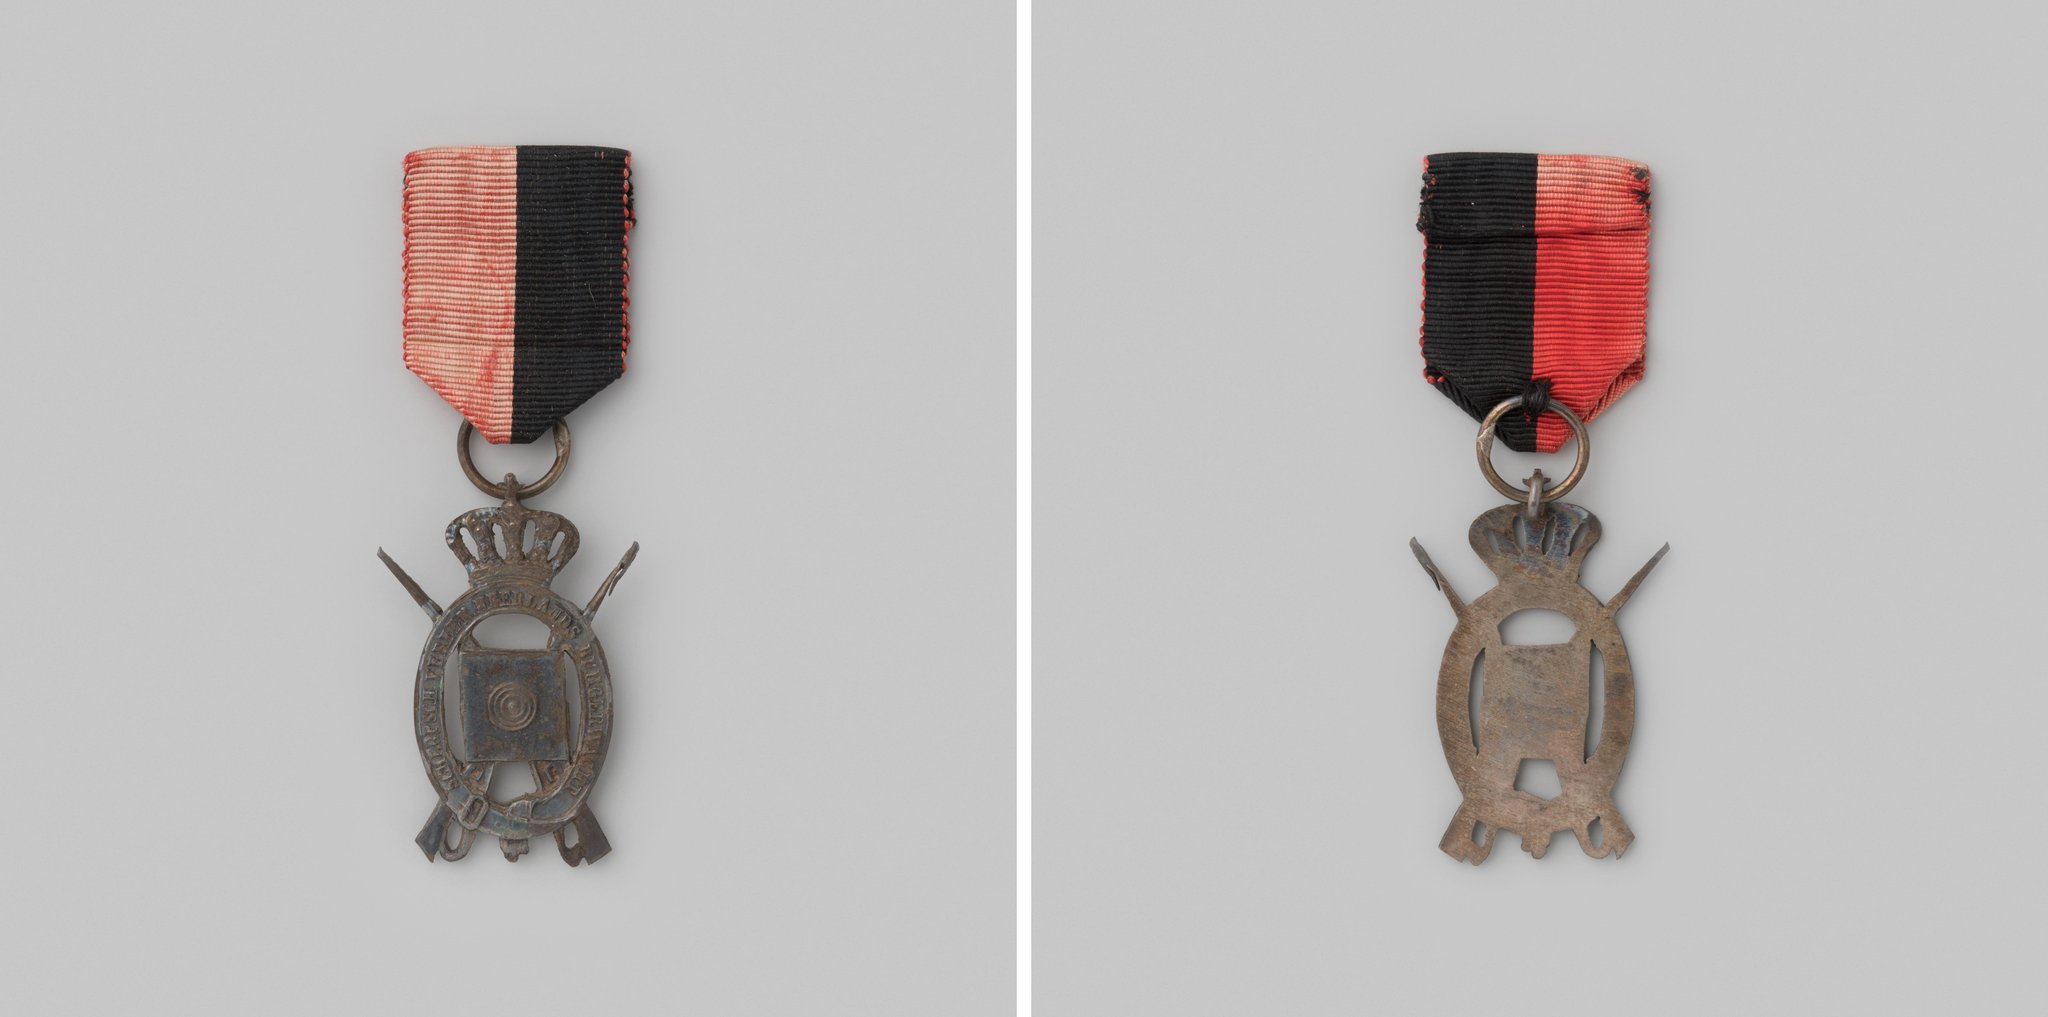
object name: insignia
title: Draagteken van de scherpschuttersvereniging Neerlands Burgerwacht te Amsterdam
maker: Anonymous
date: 1864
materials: silver, textile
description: Zilveren draagteken met oog, ring en lint. Twee gekruiste geweren waarvoor een schijf, het geheel omgeven door een banderol met opschrift: SCHERPSCH. VEREEN. NEERLANDS BURGERWACHT en gedekt door een koningskroon. Dit draagteken wordt gedragen aan een rood-zart geribd gewaterd zijden lint.